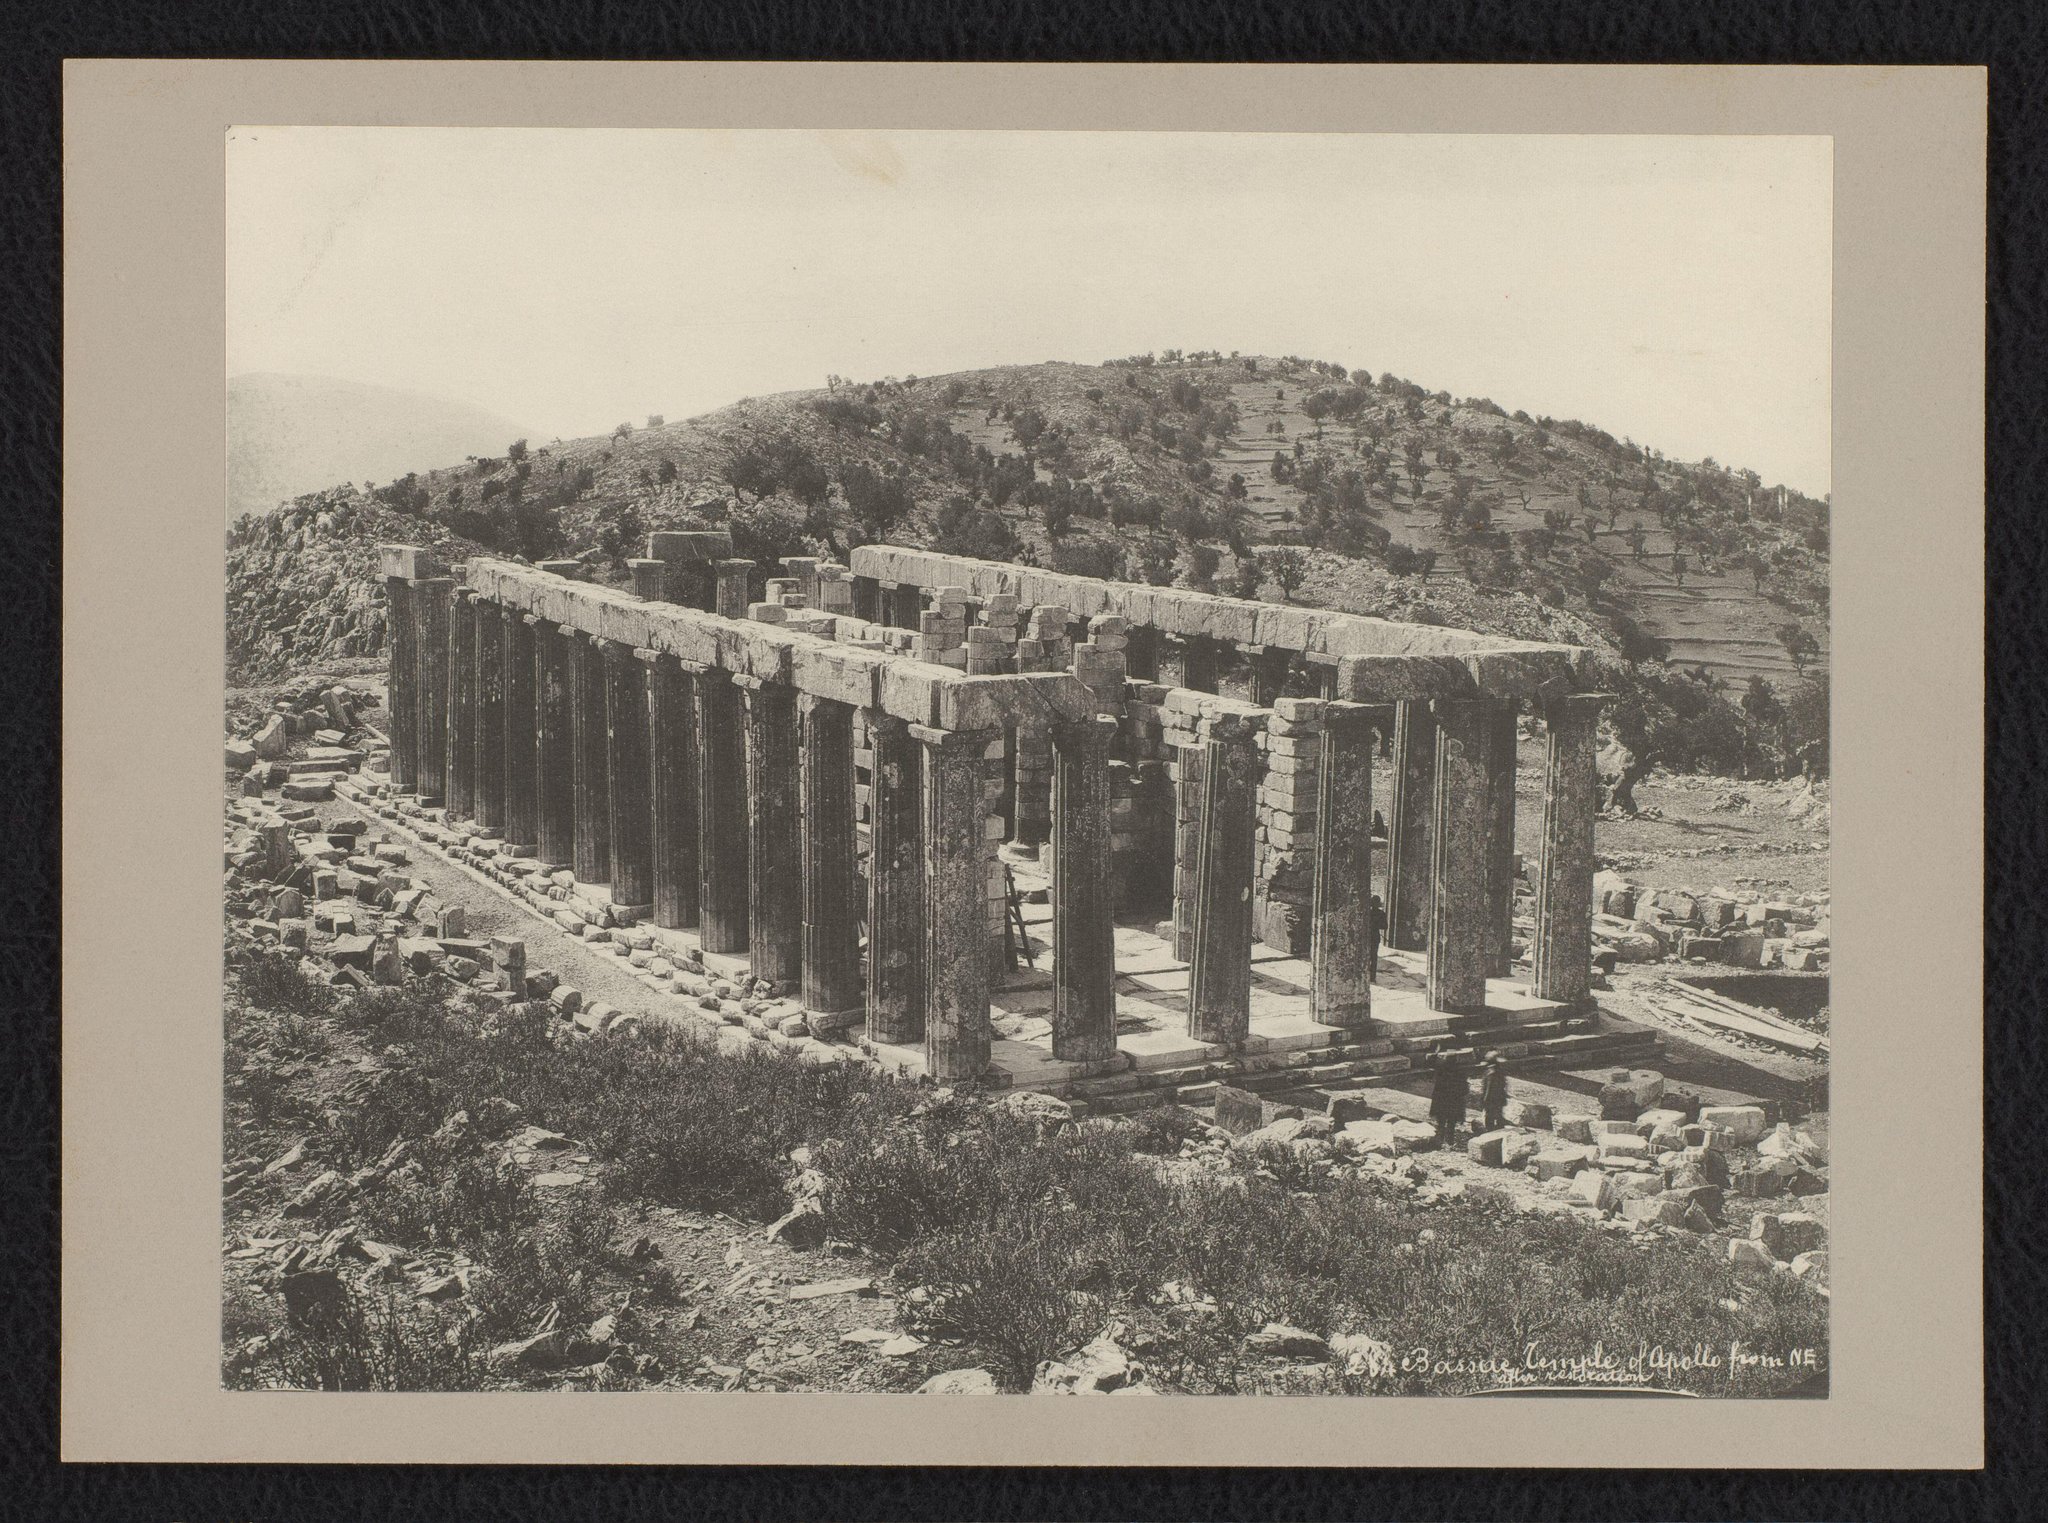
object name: photograph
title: Tempel van Apollo bij Bassae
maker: Anonymous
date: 1895-1915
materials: cardboard, paper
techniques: photograph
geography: peloponnese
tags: pelopónnesos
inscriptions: number: ‘3.’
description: Tempel van Apollo vanuit het noordoosten gefotografeerd.